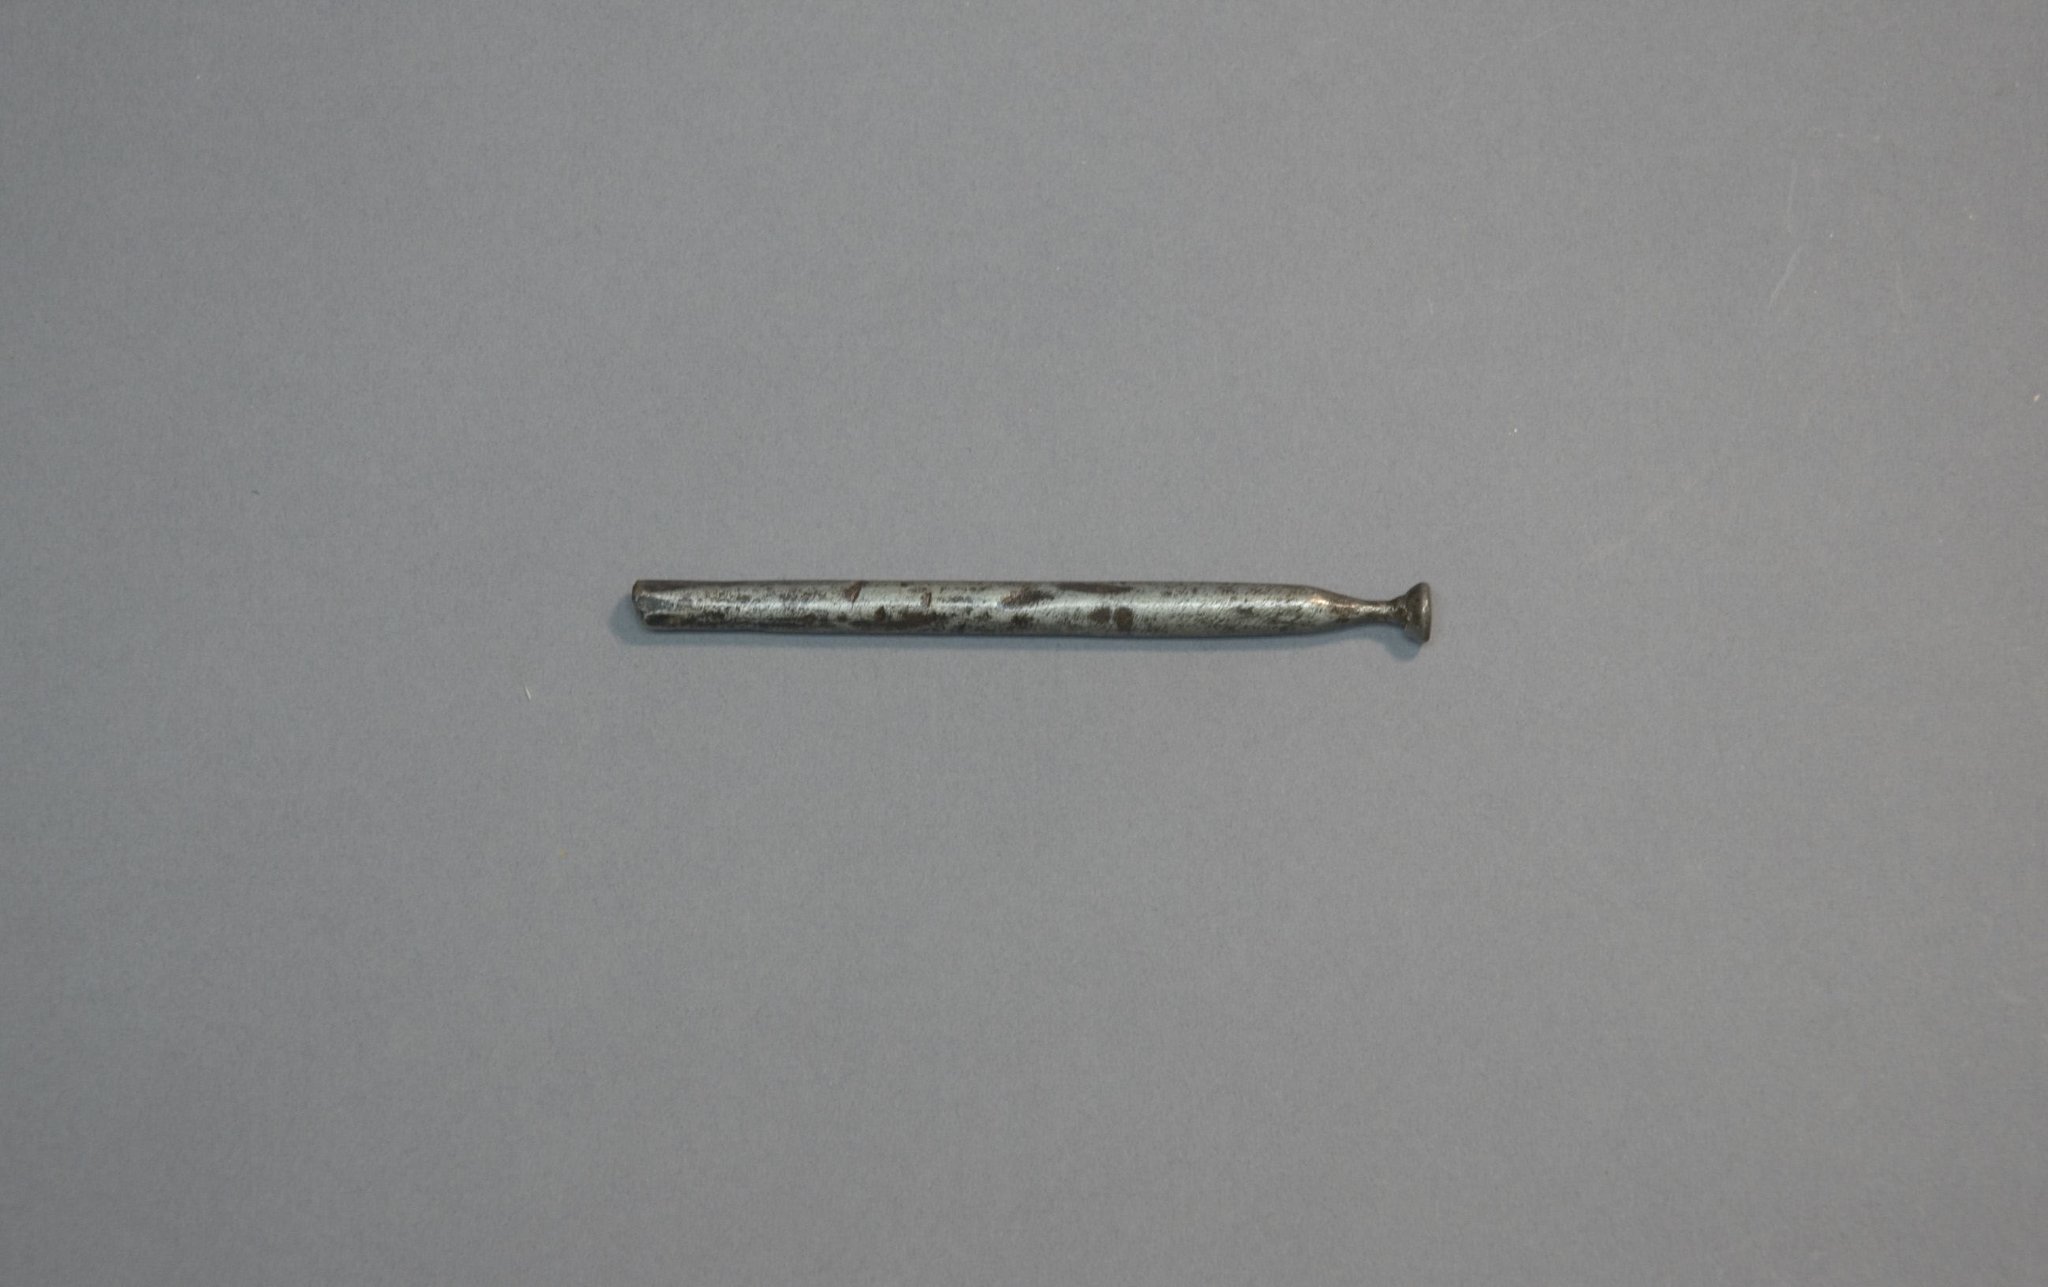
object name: jade carving tool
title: Drill for carving jade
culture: chinese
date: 1901-2000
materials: steel